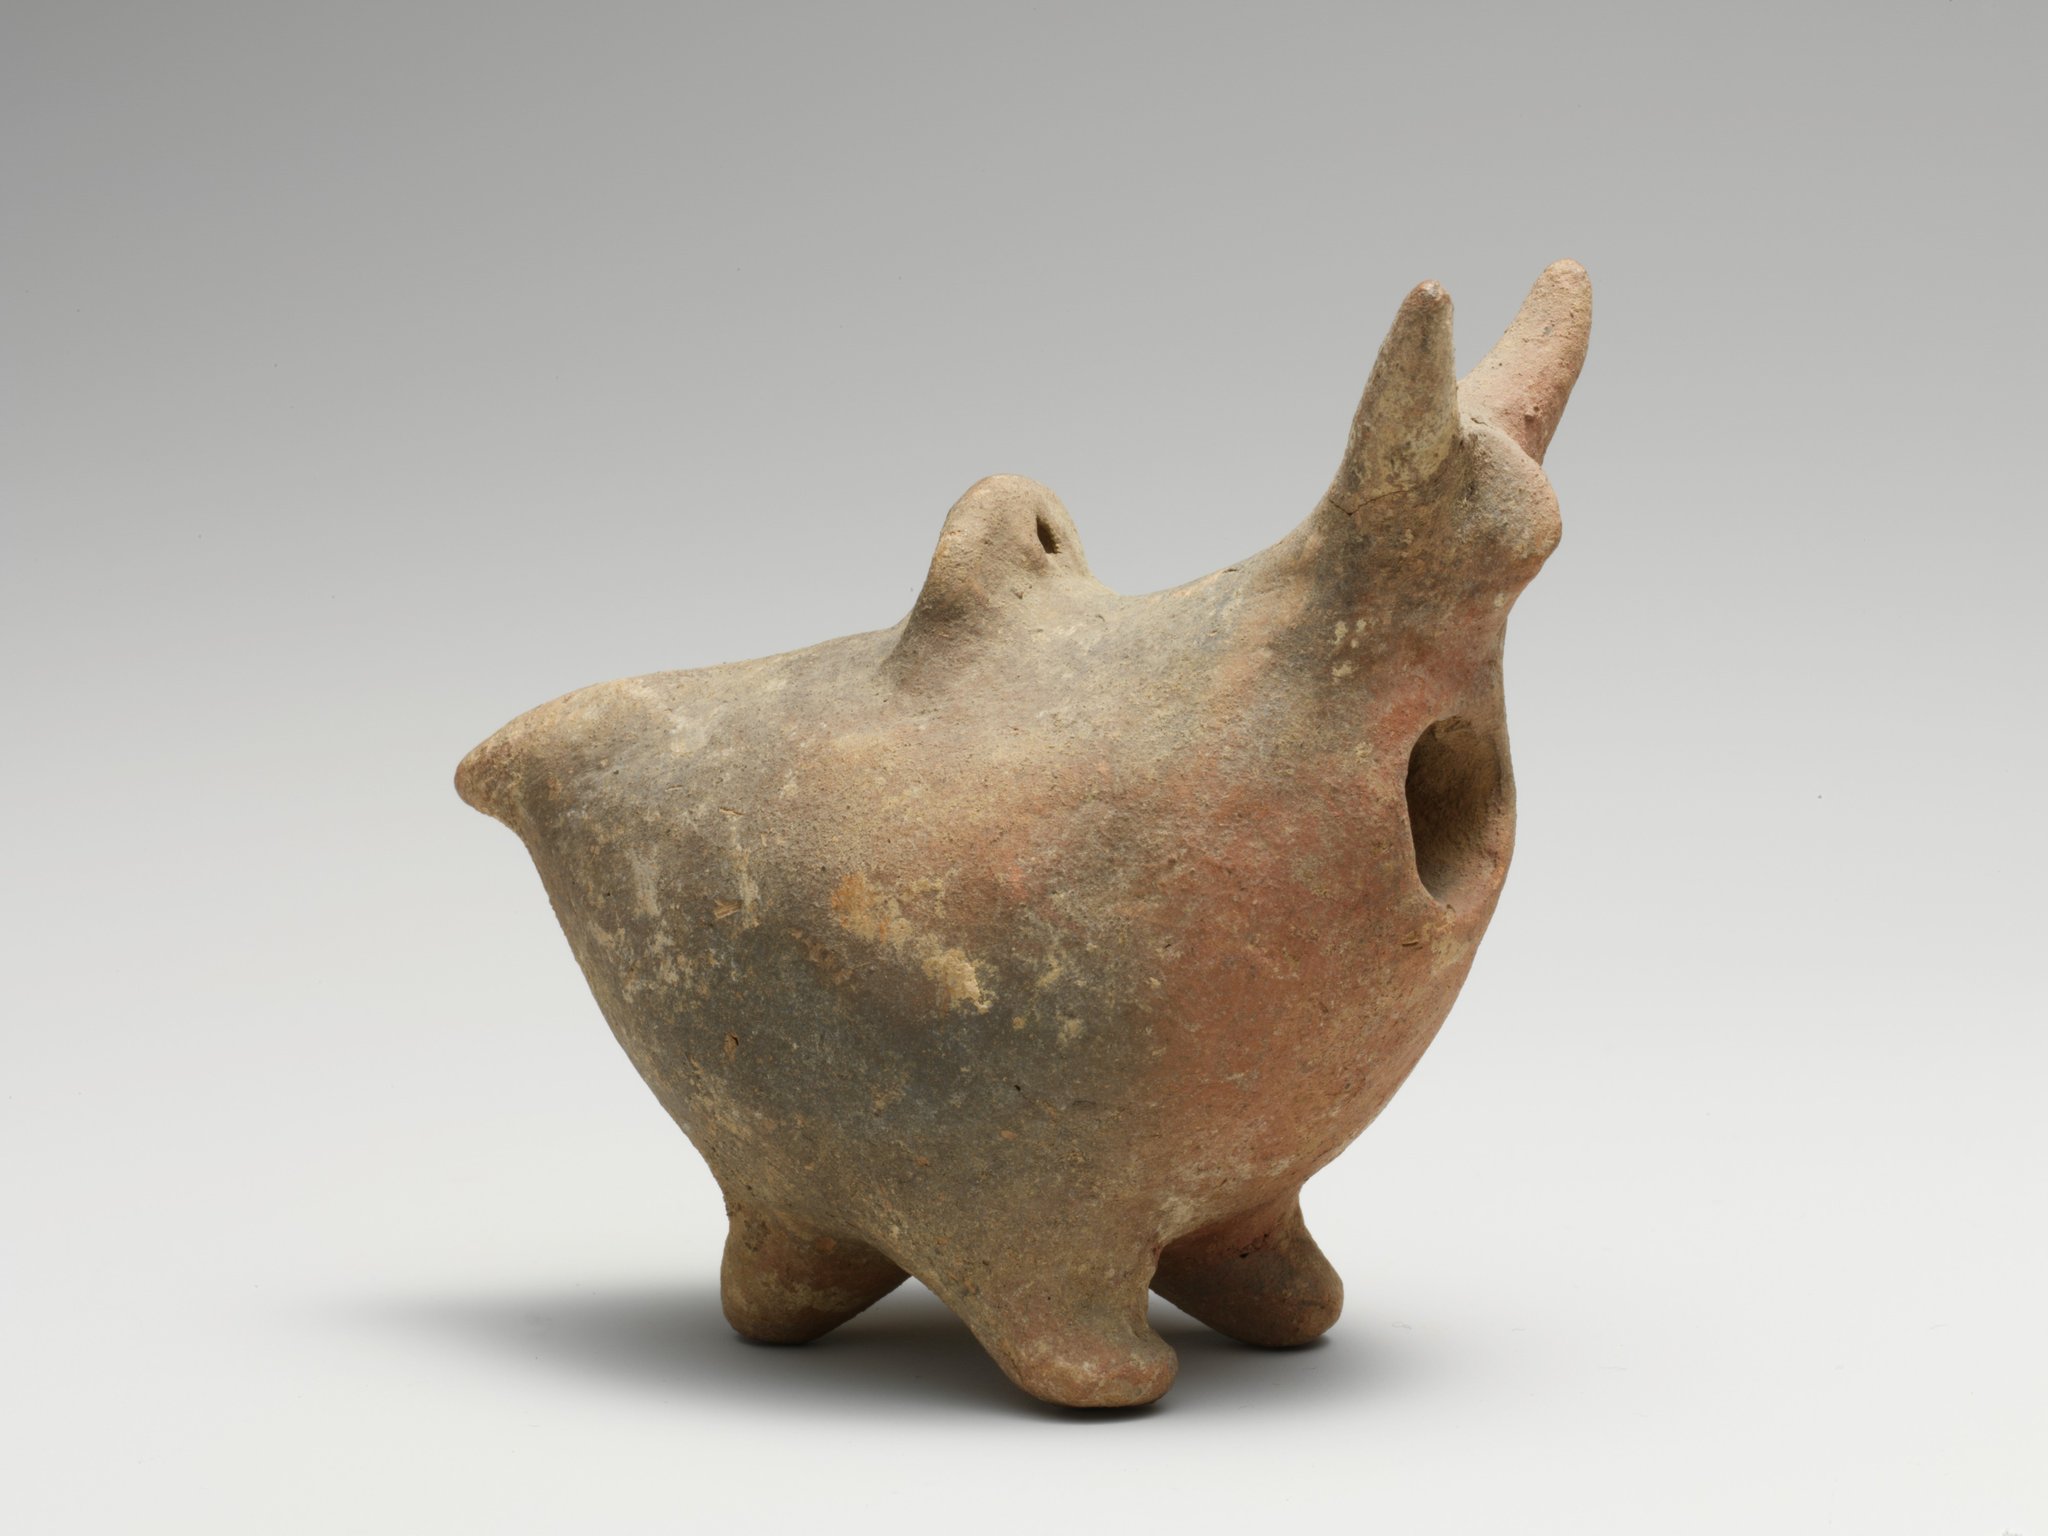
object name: askos in the form of an animal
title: Terracotta zoomorphic askos (vessel)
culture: cypriot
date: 2500-1900 BCE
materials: terracotta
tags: animals